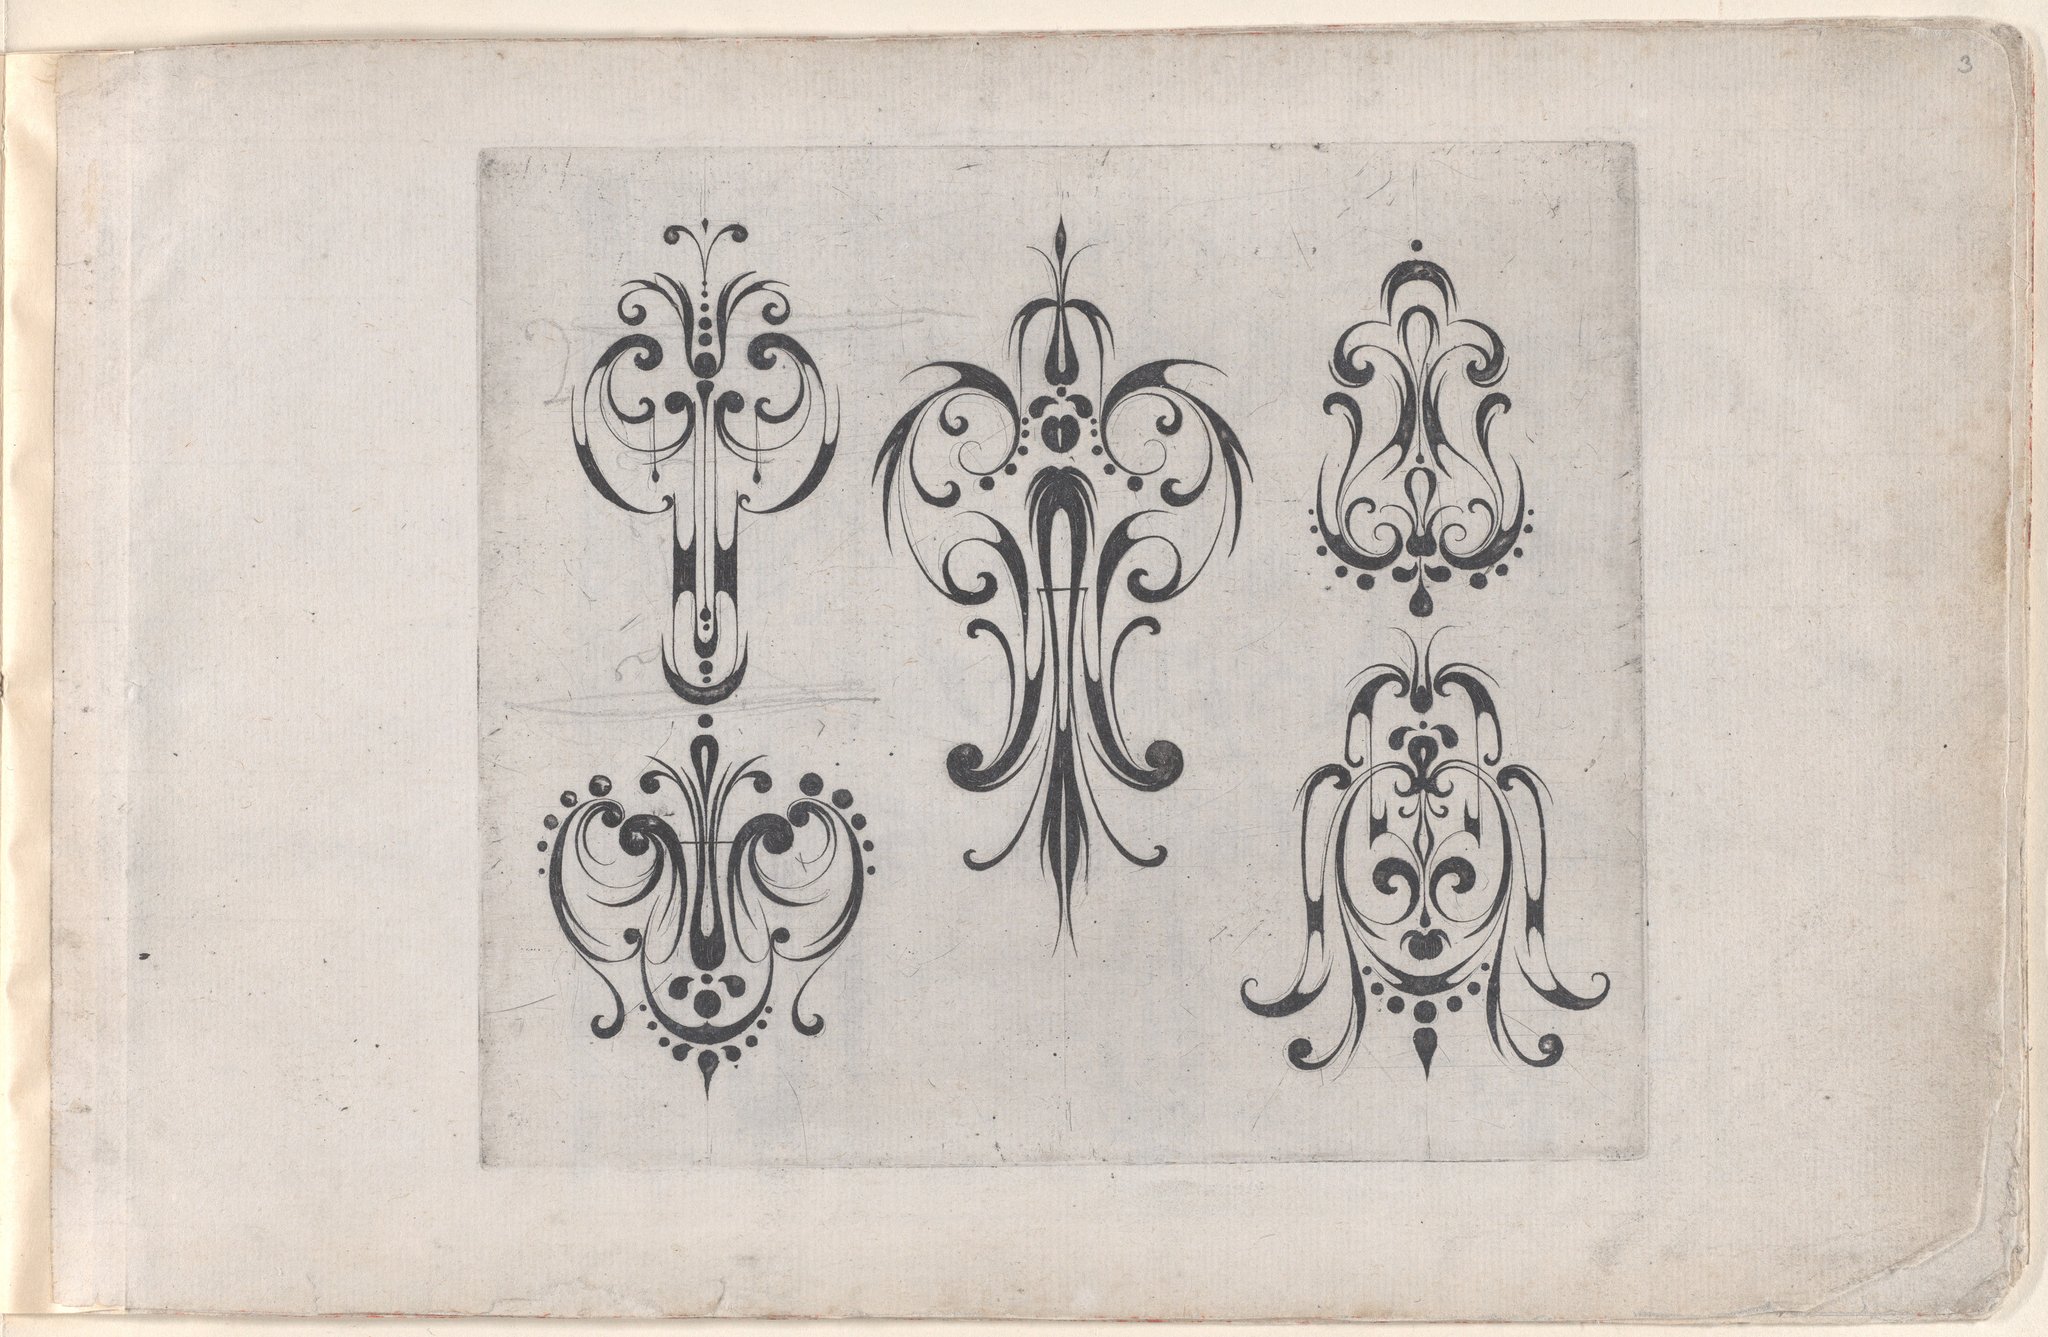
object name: album print ornament architecture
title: Plate from "Grateske voer golt smeden Schrijnwerkers Ende andere des nodich hebbende"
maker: meinert gelijs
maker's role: artist and engraver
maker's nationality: dutch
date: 1610-1630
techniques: embroidery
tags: ornament